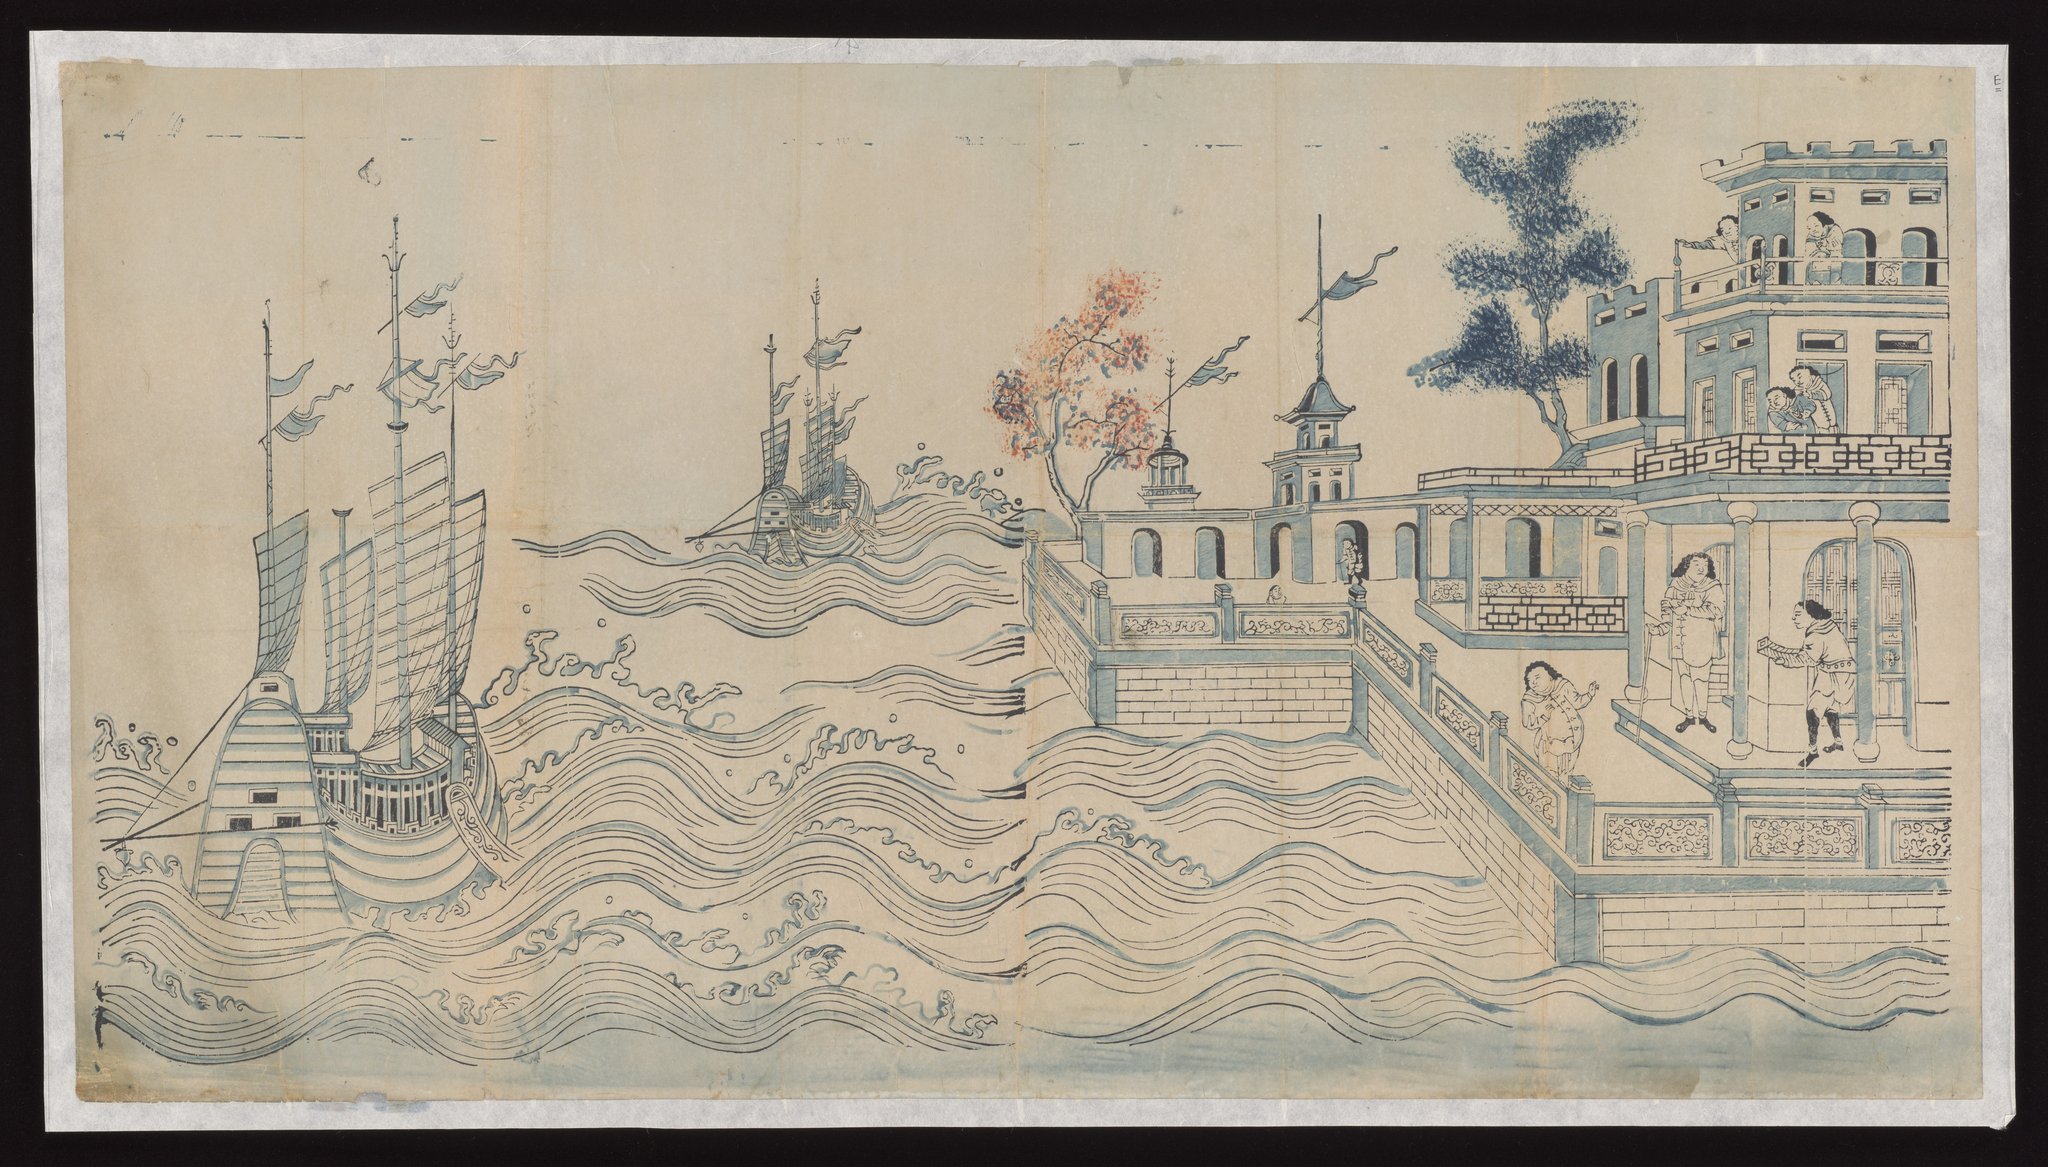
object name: print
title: Scene of Westerners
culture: chinese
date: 1701-1800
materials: ink, paper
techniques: hand coloring, woodblock print